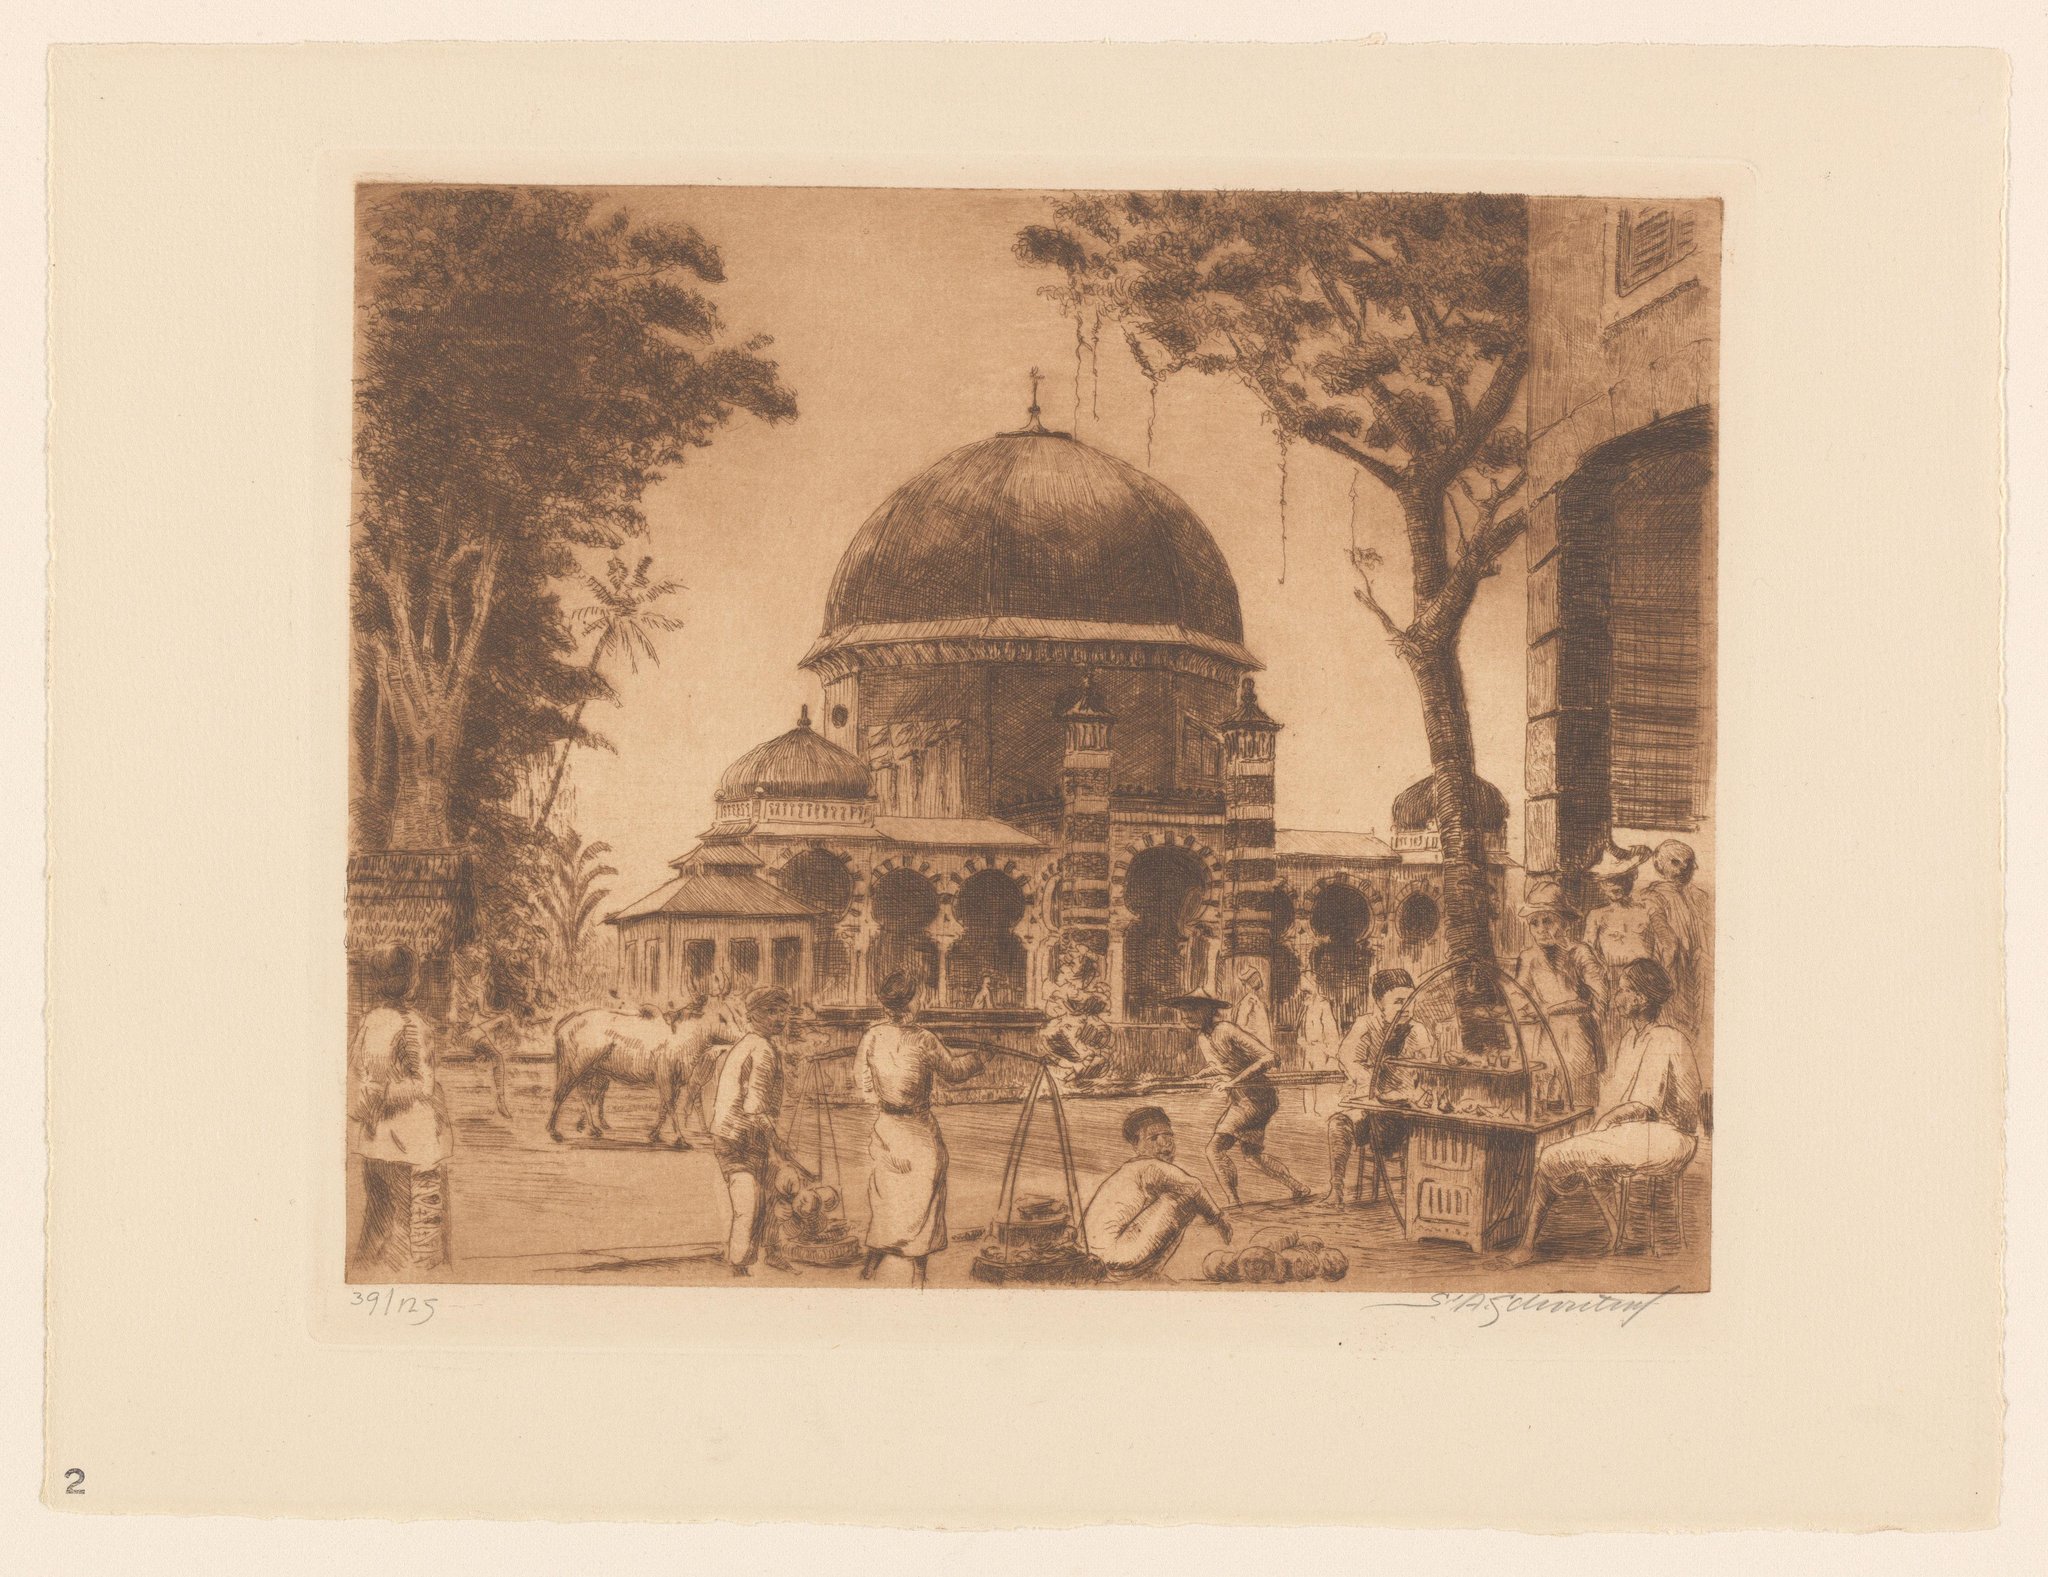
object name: print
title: Gezicht op een moskee in Labuhan Deli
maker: st. a. schouten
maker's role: print maker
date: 1929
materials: paper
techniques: etching, intaglio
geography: amsterdam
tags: temple, shrine ~ islam, mohammedanism, street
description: Aangezien geboorte- en sterfdatum van de kunstenaar onbekend zijn, is voor de rechtenbepaling van dit object de productiedatum gehanteerd.